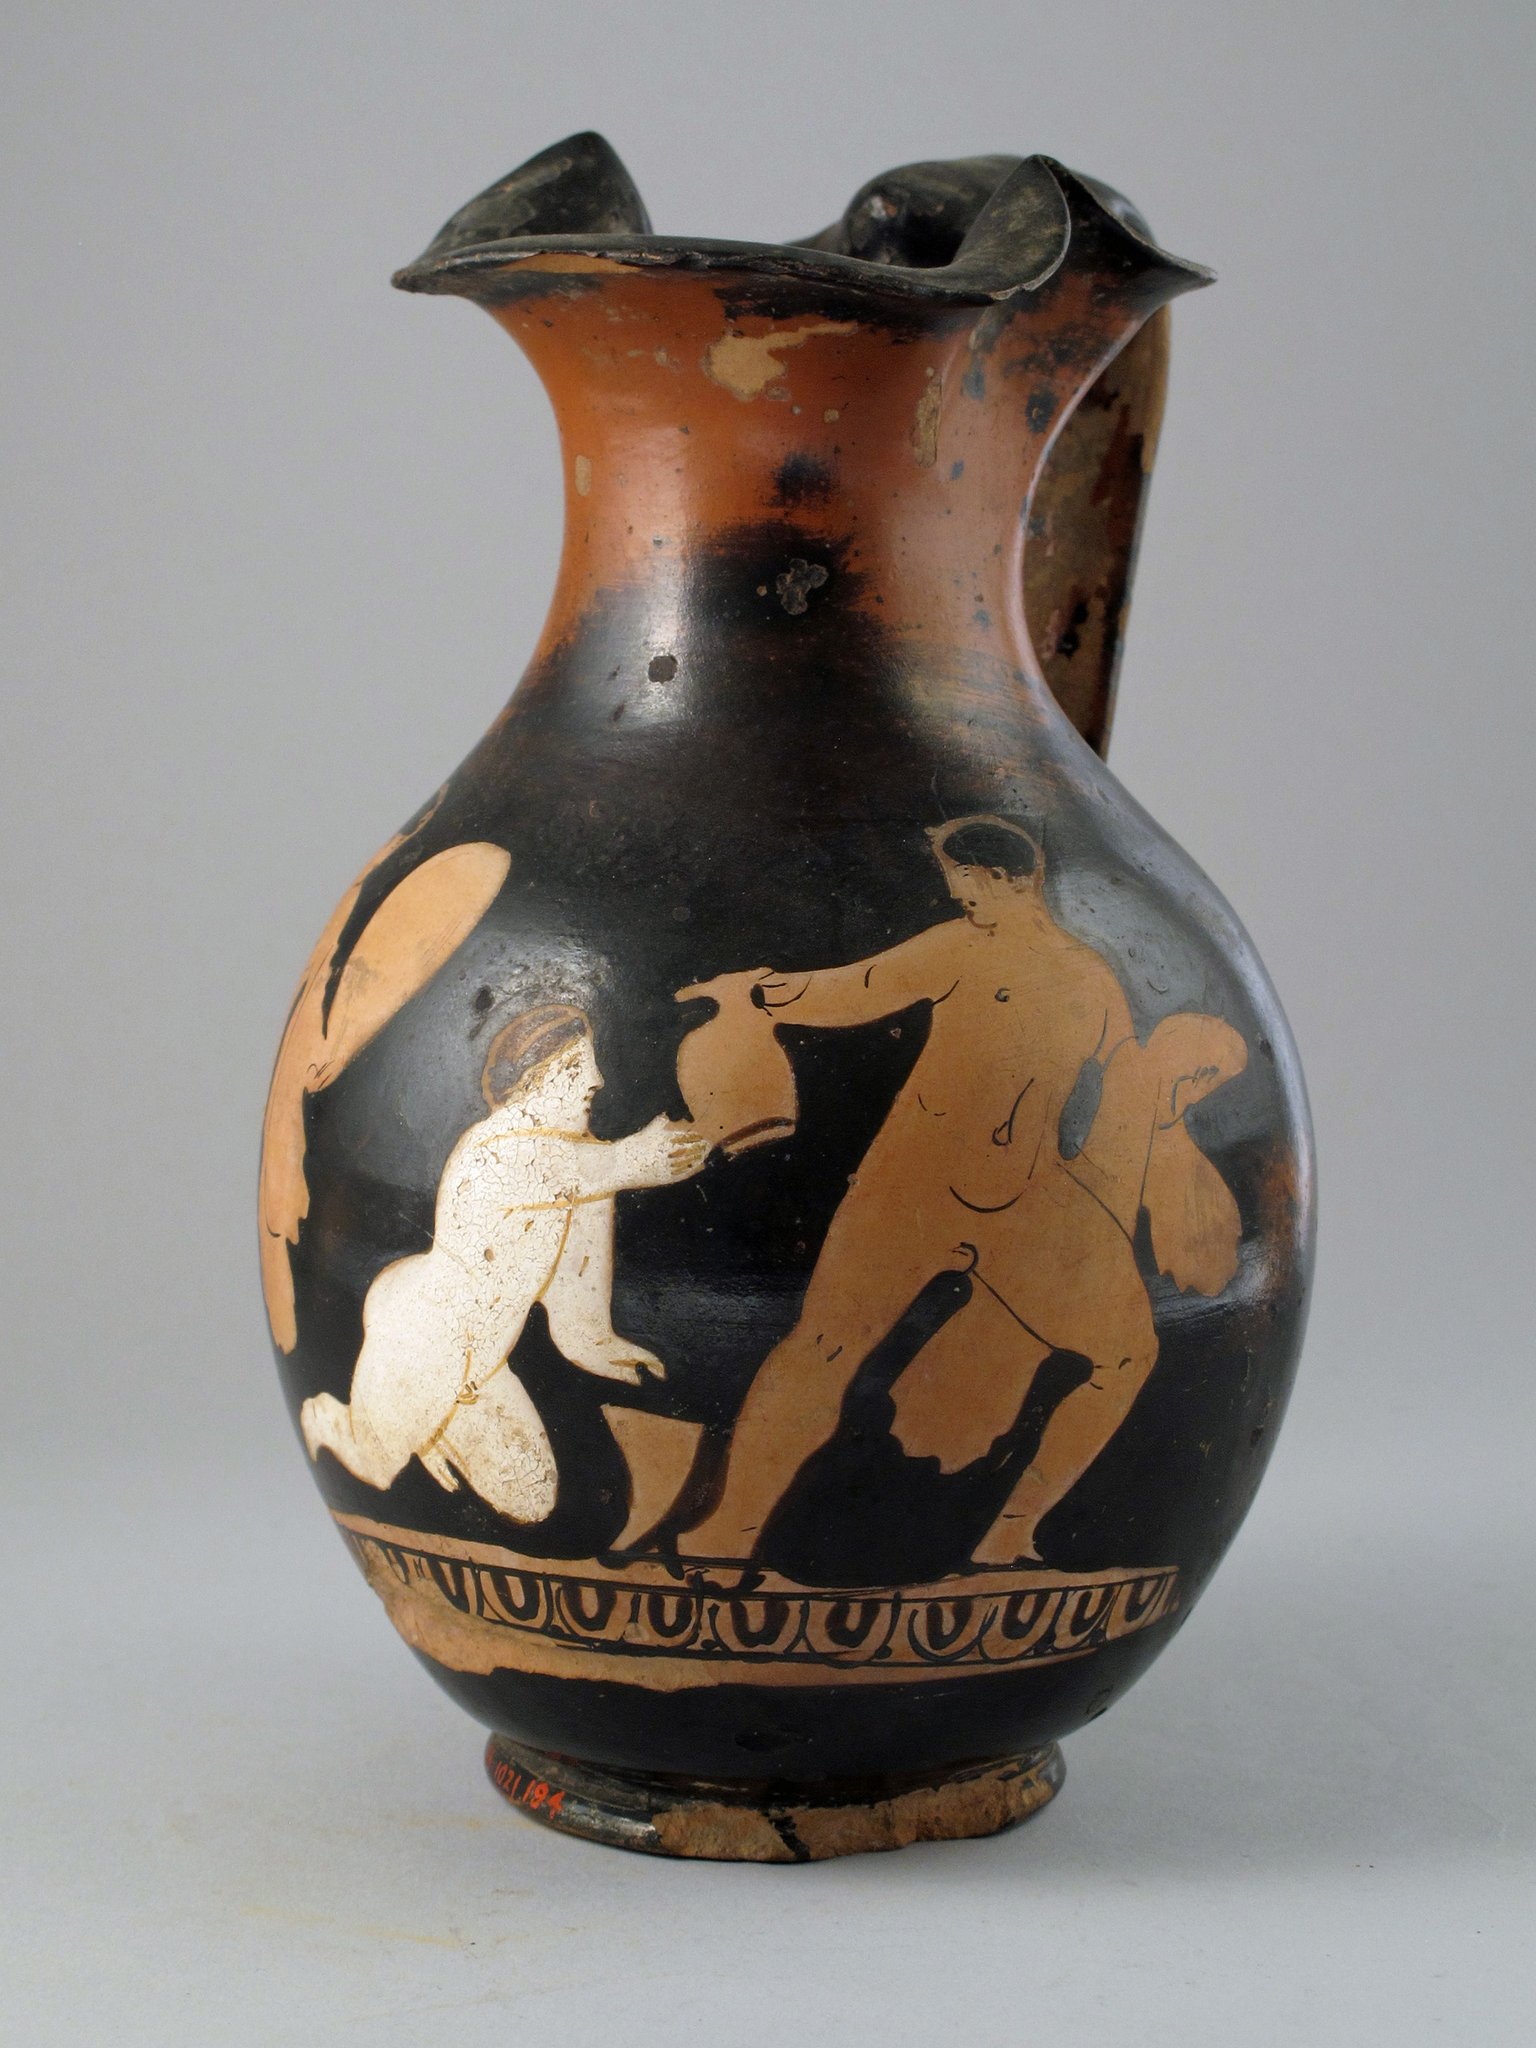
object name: oinochoe, chou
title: Oinochoe, chous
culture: greek, attic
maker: painter of the ferrara choes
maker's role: artist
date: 400-368 BCE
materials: terracotta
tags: male nudes,female nudes